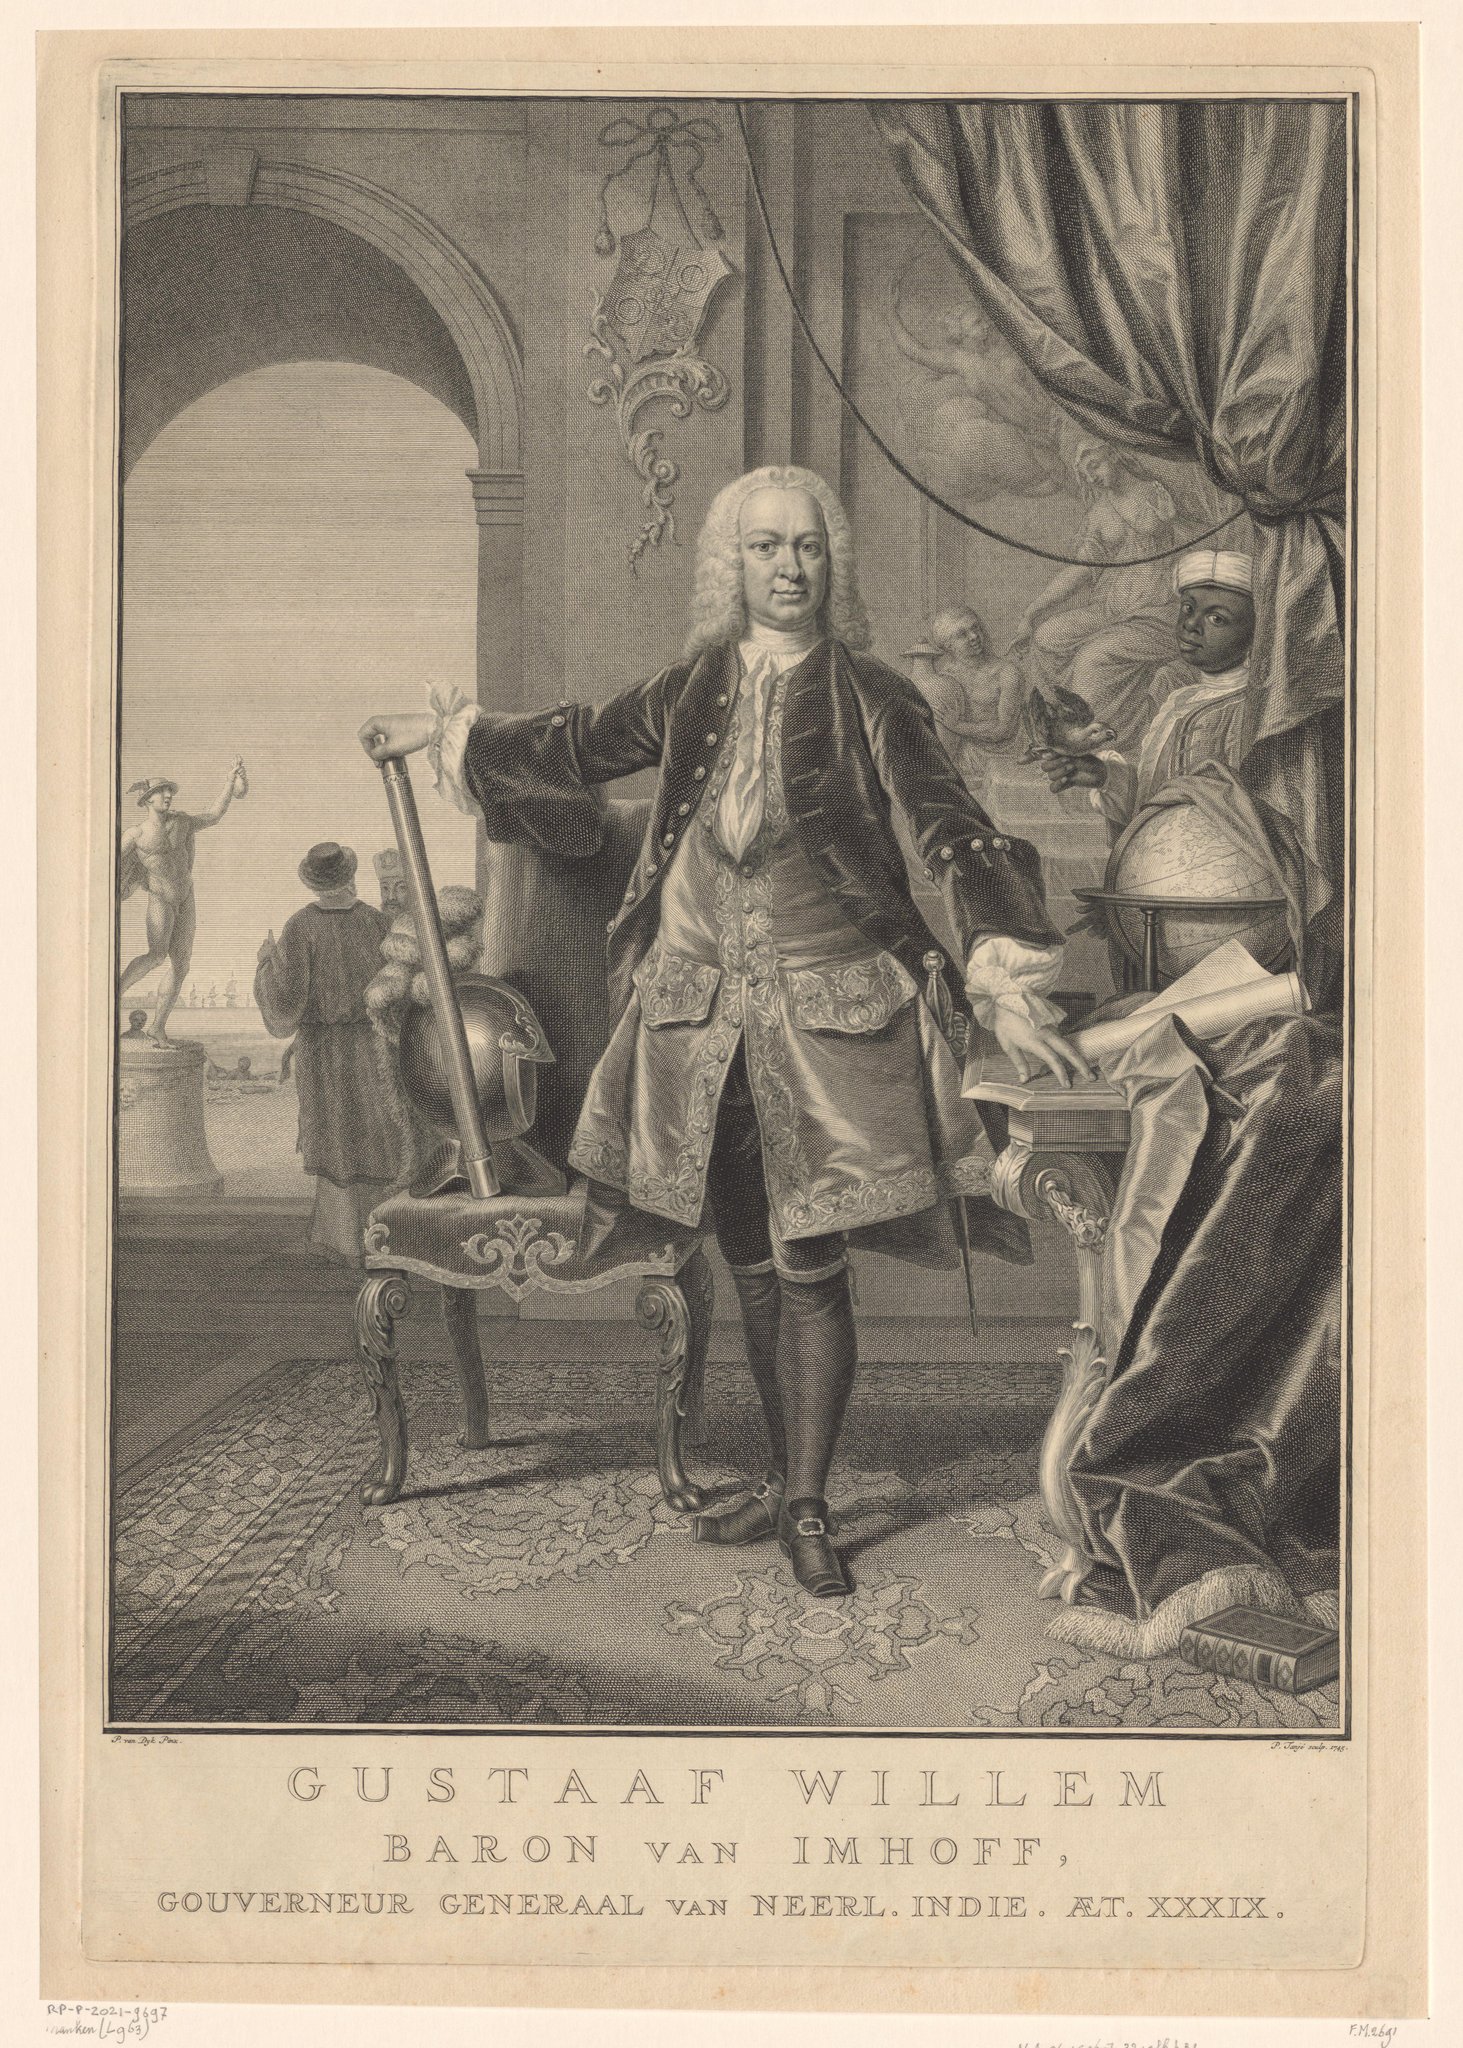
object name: print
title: Portret van Gustaaf Willem, baron van Imhoff, op 39-jarige leeftijd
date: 1745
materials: paper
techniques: engraving, etching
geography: amsterdam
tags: batavia, commander-in-chief, general, marshal, historical persons, sea (seascape), interior of the house, globe, specific aspects, allegorical aspects of mercury; mercury as patron, house personnel, servants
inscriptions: collector's mark: Lugt 963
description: Portret van Gustaaf Willem, baron van Imhoff (I), gouverneur-generaal van Nederlands-Indië. Hij staat met de commandostaf in zijn hand bij een tafel, waarop een globe, in een kamer. Achter hem een tot slaaf gemaakte bediende met een vogel op de hand. Door de poort links is een standbeeld van Mercurius, de god van de handel, en de zee met schepen te zien.